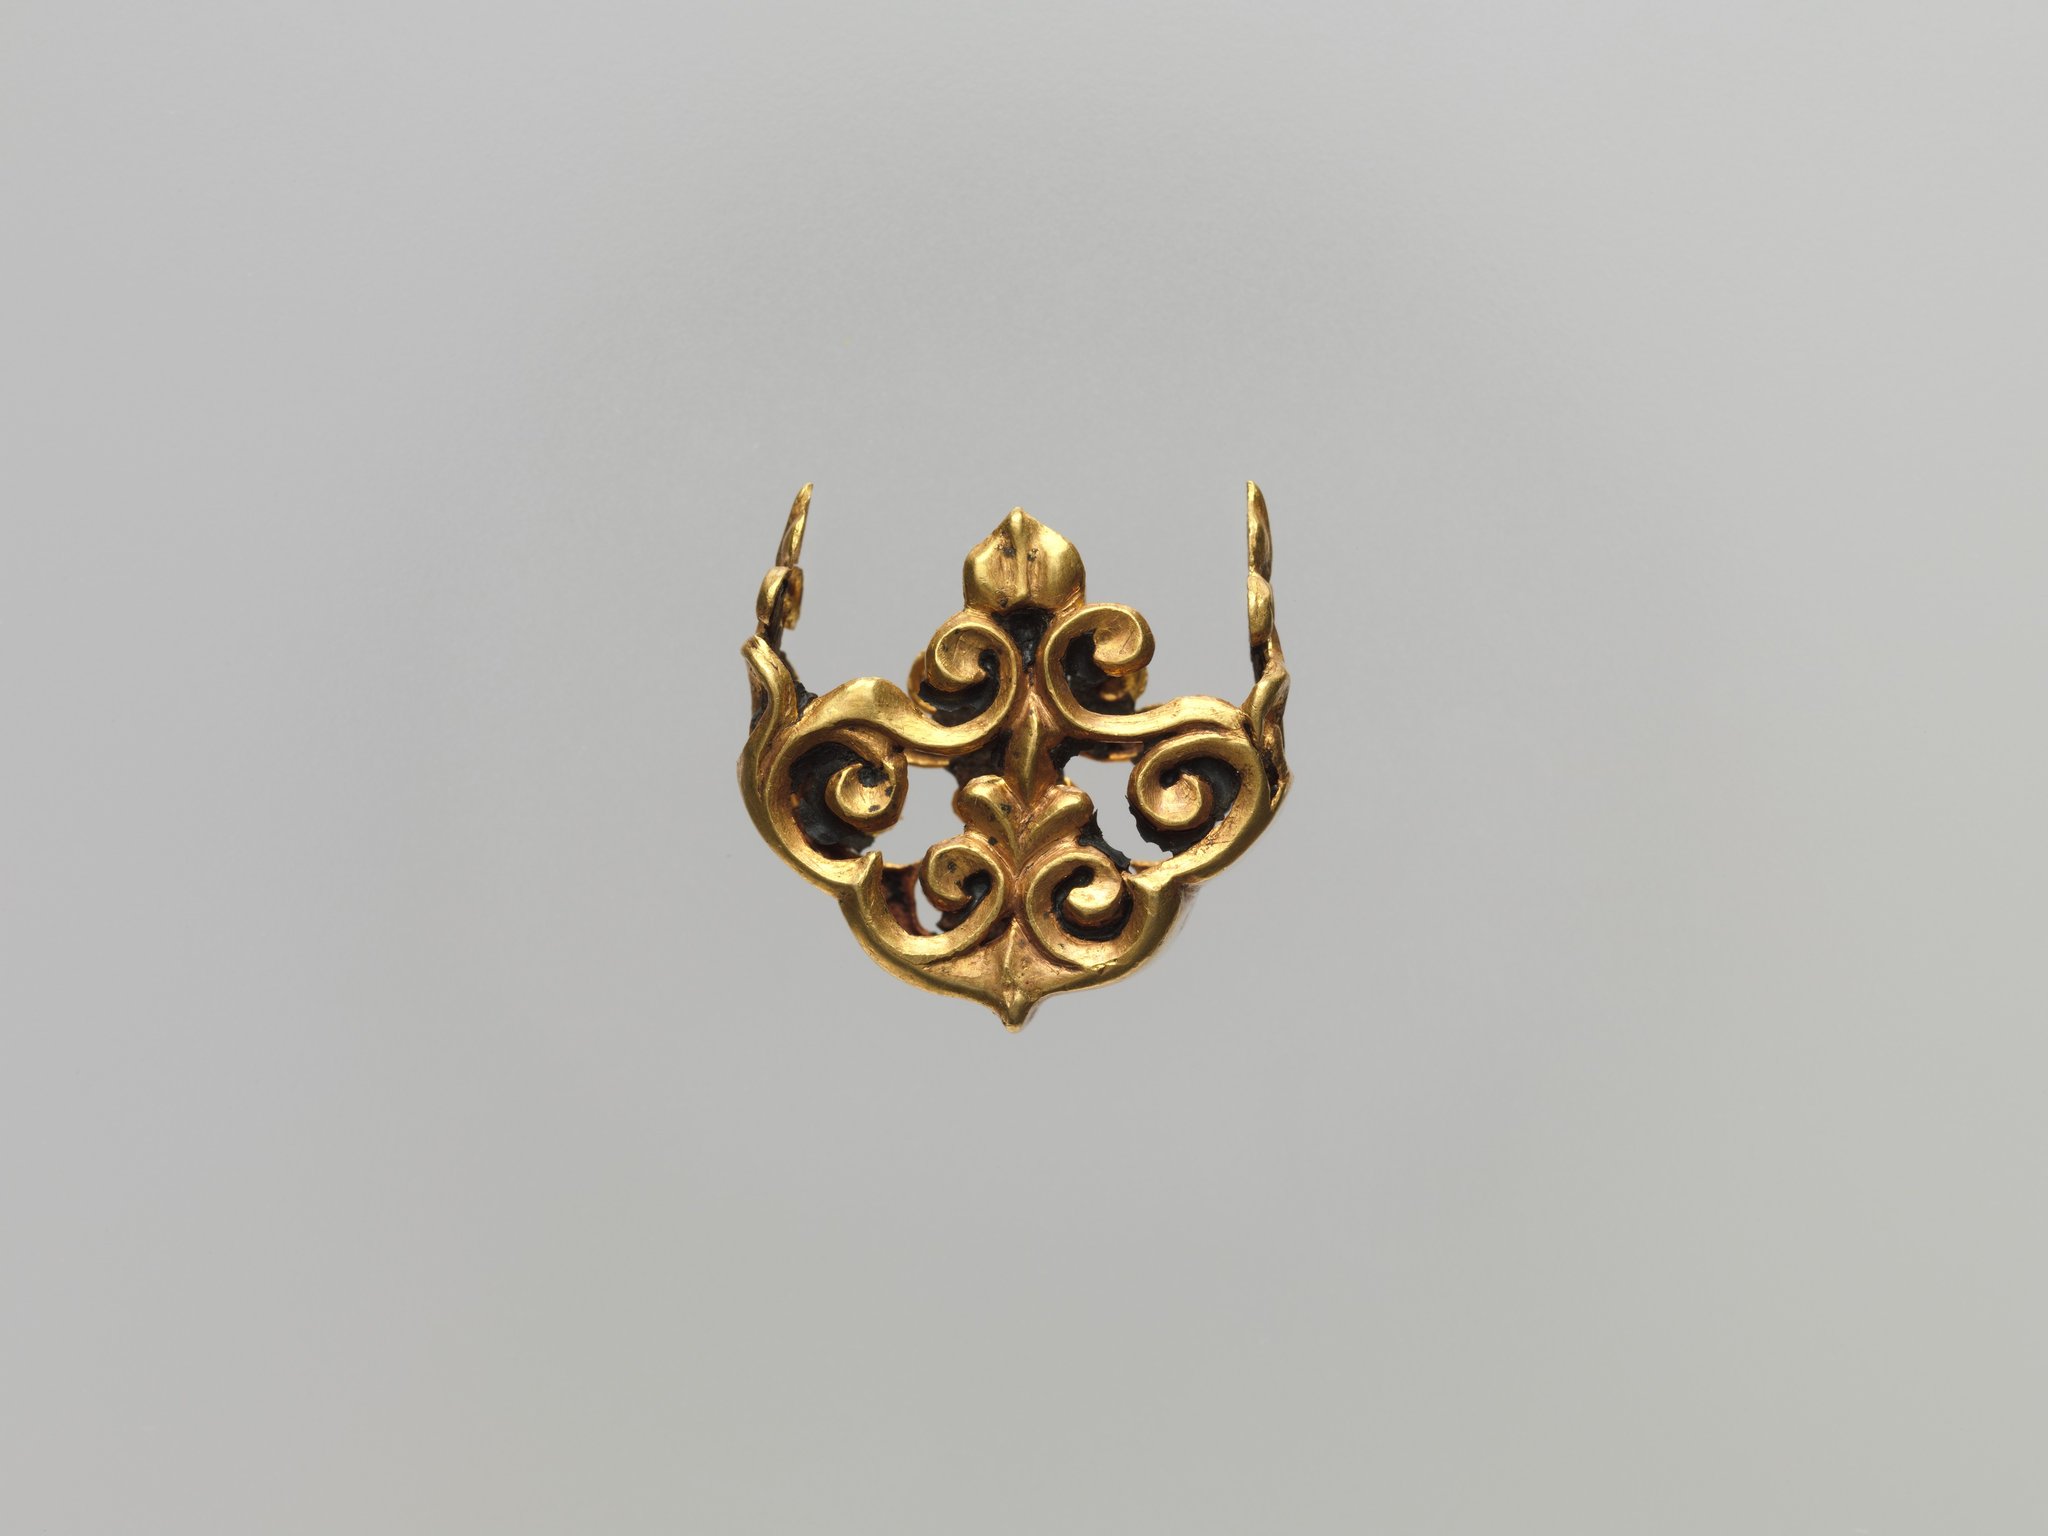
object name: fitting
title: Openwork Fitting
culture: chinese or central asian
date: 601-900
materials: gold